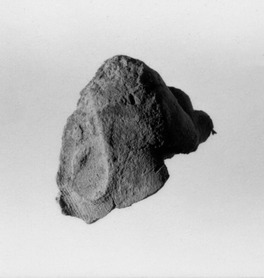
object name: sealing, nebmaatre, amenhotep iii, isi, horus, ke nesu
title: Document Sealing With the Throne Name of Amenhotep III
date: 1390-1352 BCE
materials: mud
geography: egypt